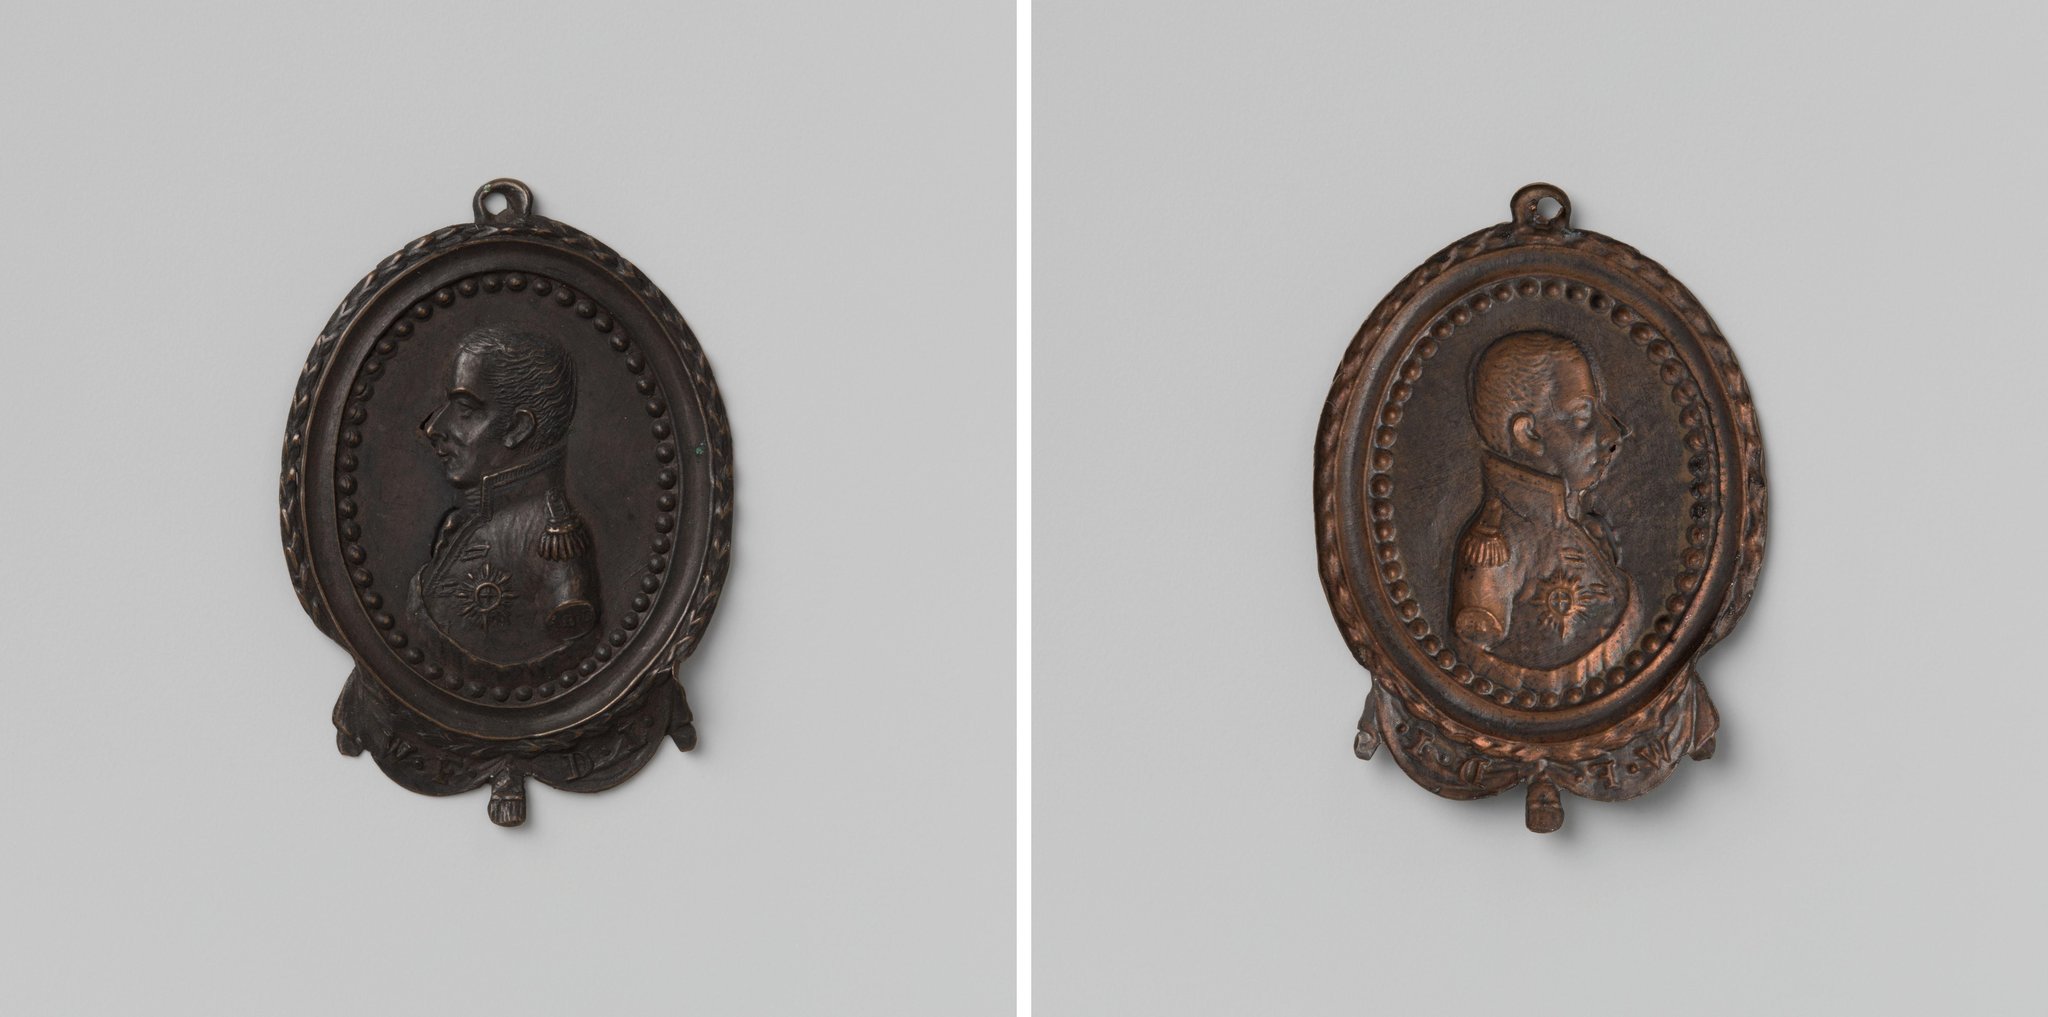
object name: insignia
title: Willem Frederik, prins van Oranje-Nassau, souverein vorst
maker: Anonymous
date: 1813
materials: copper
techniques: striking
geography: netherlands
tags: the hague, berlin, william i of the netherlands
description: Eenzijdig koperen ovaal draagteken met draagoog en aan onderzijde doek. Voorzijde: borststuk man binnen parelrand en lauwerkrans; op doek: monogram. Keerzijde: blanco.